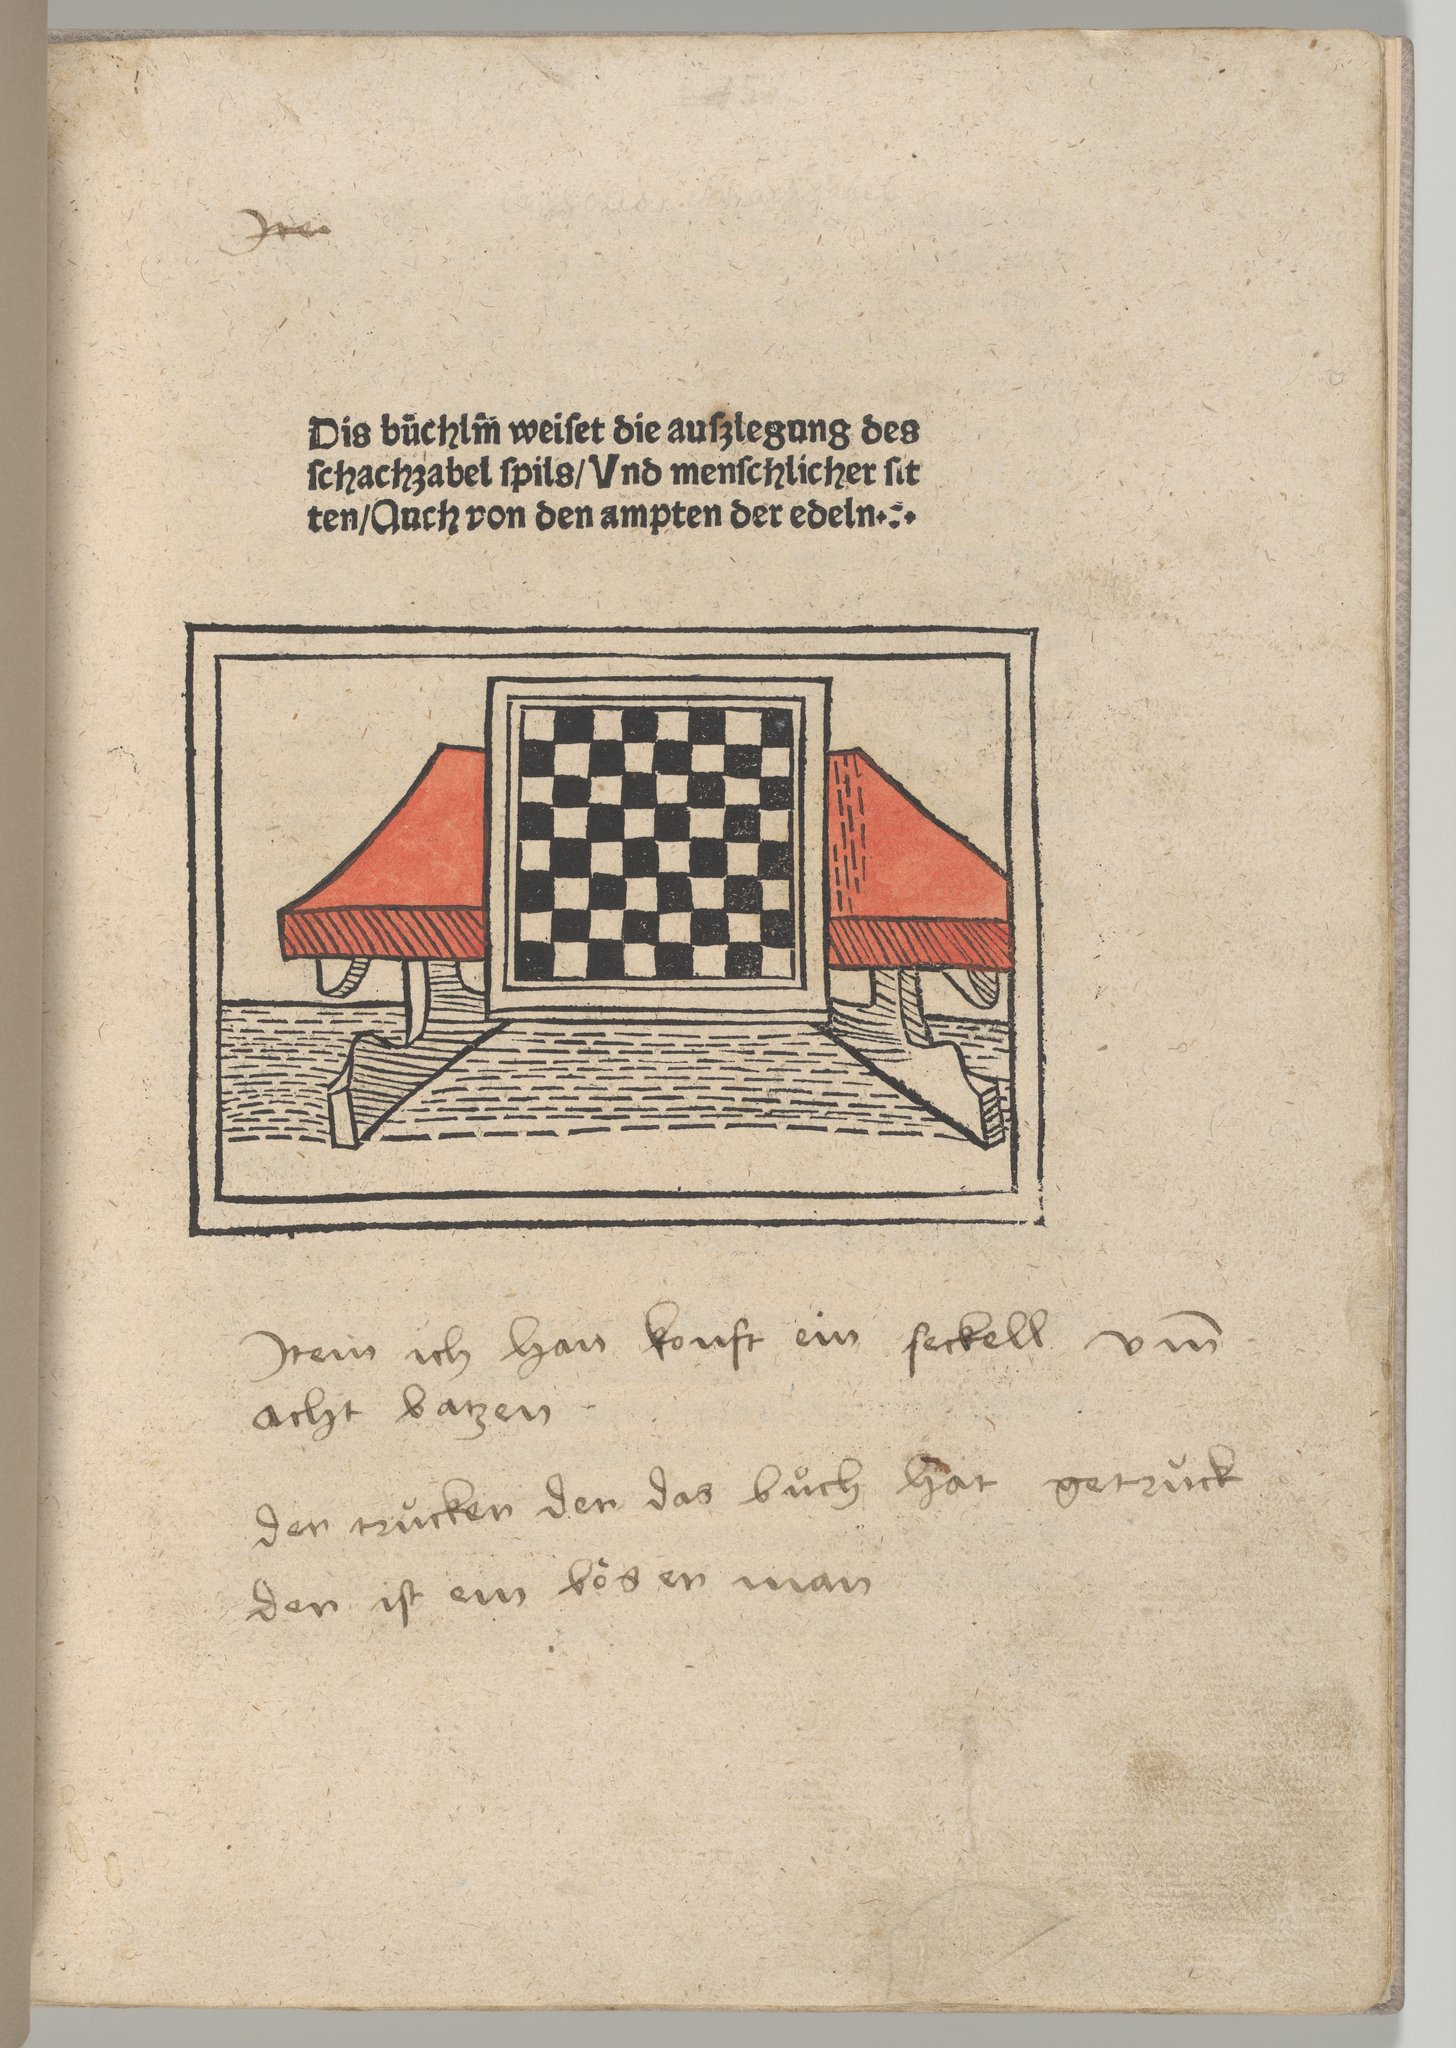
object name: book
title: The Book of Chess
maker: jacobus de cessolis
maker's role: author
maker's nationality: italian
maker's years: 1288-1322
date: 1483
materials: watercolor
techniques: letterpress, woodcut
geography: strasbourg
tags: chess